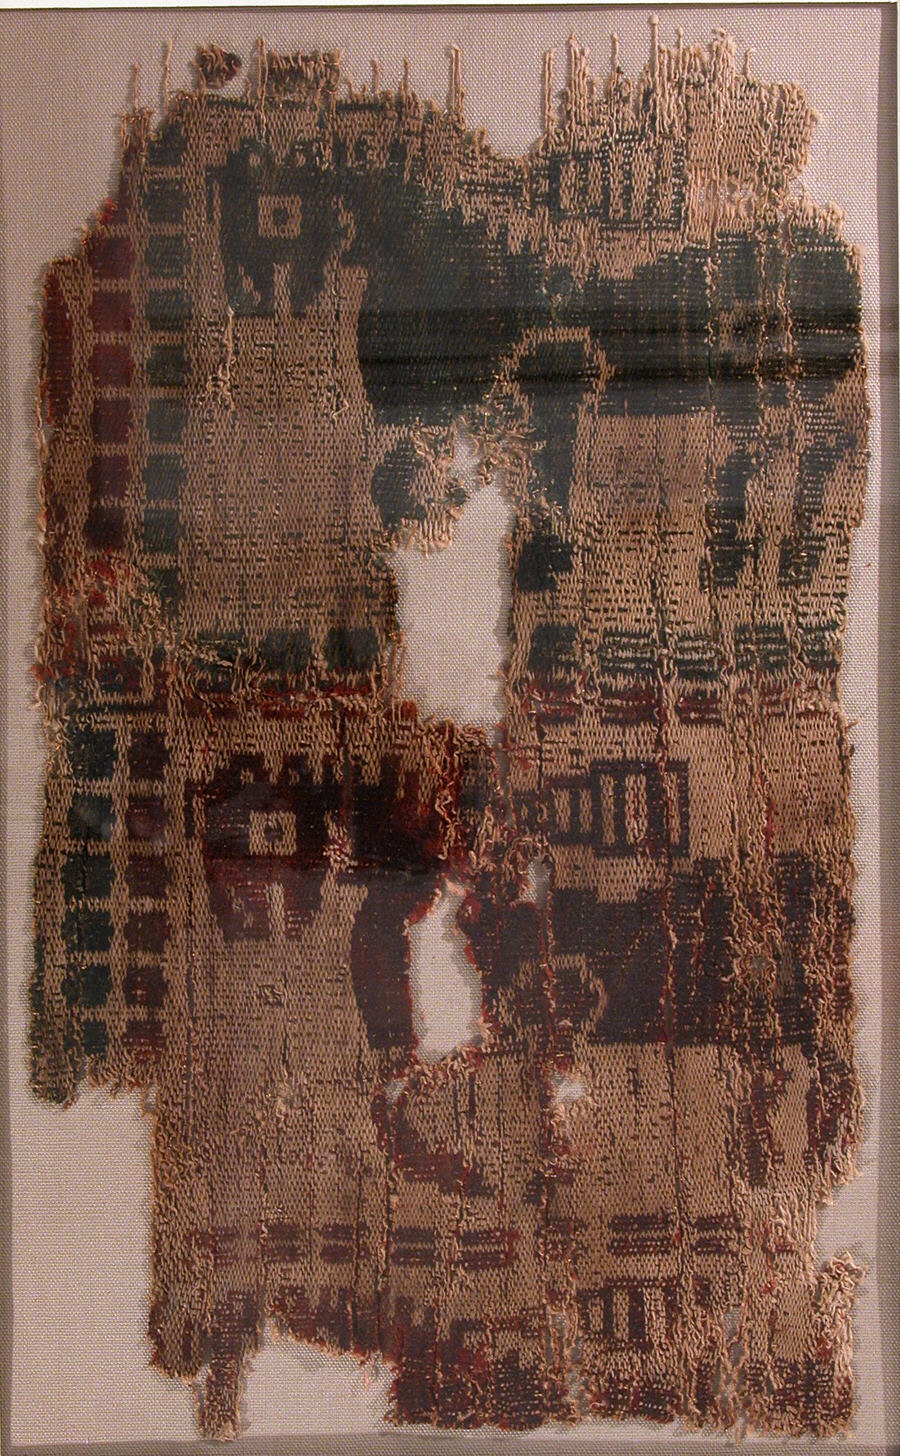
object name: fragment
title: Textile Fragment with Horses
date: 601-900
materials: cotton, wool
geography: iran